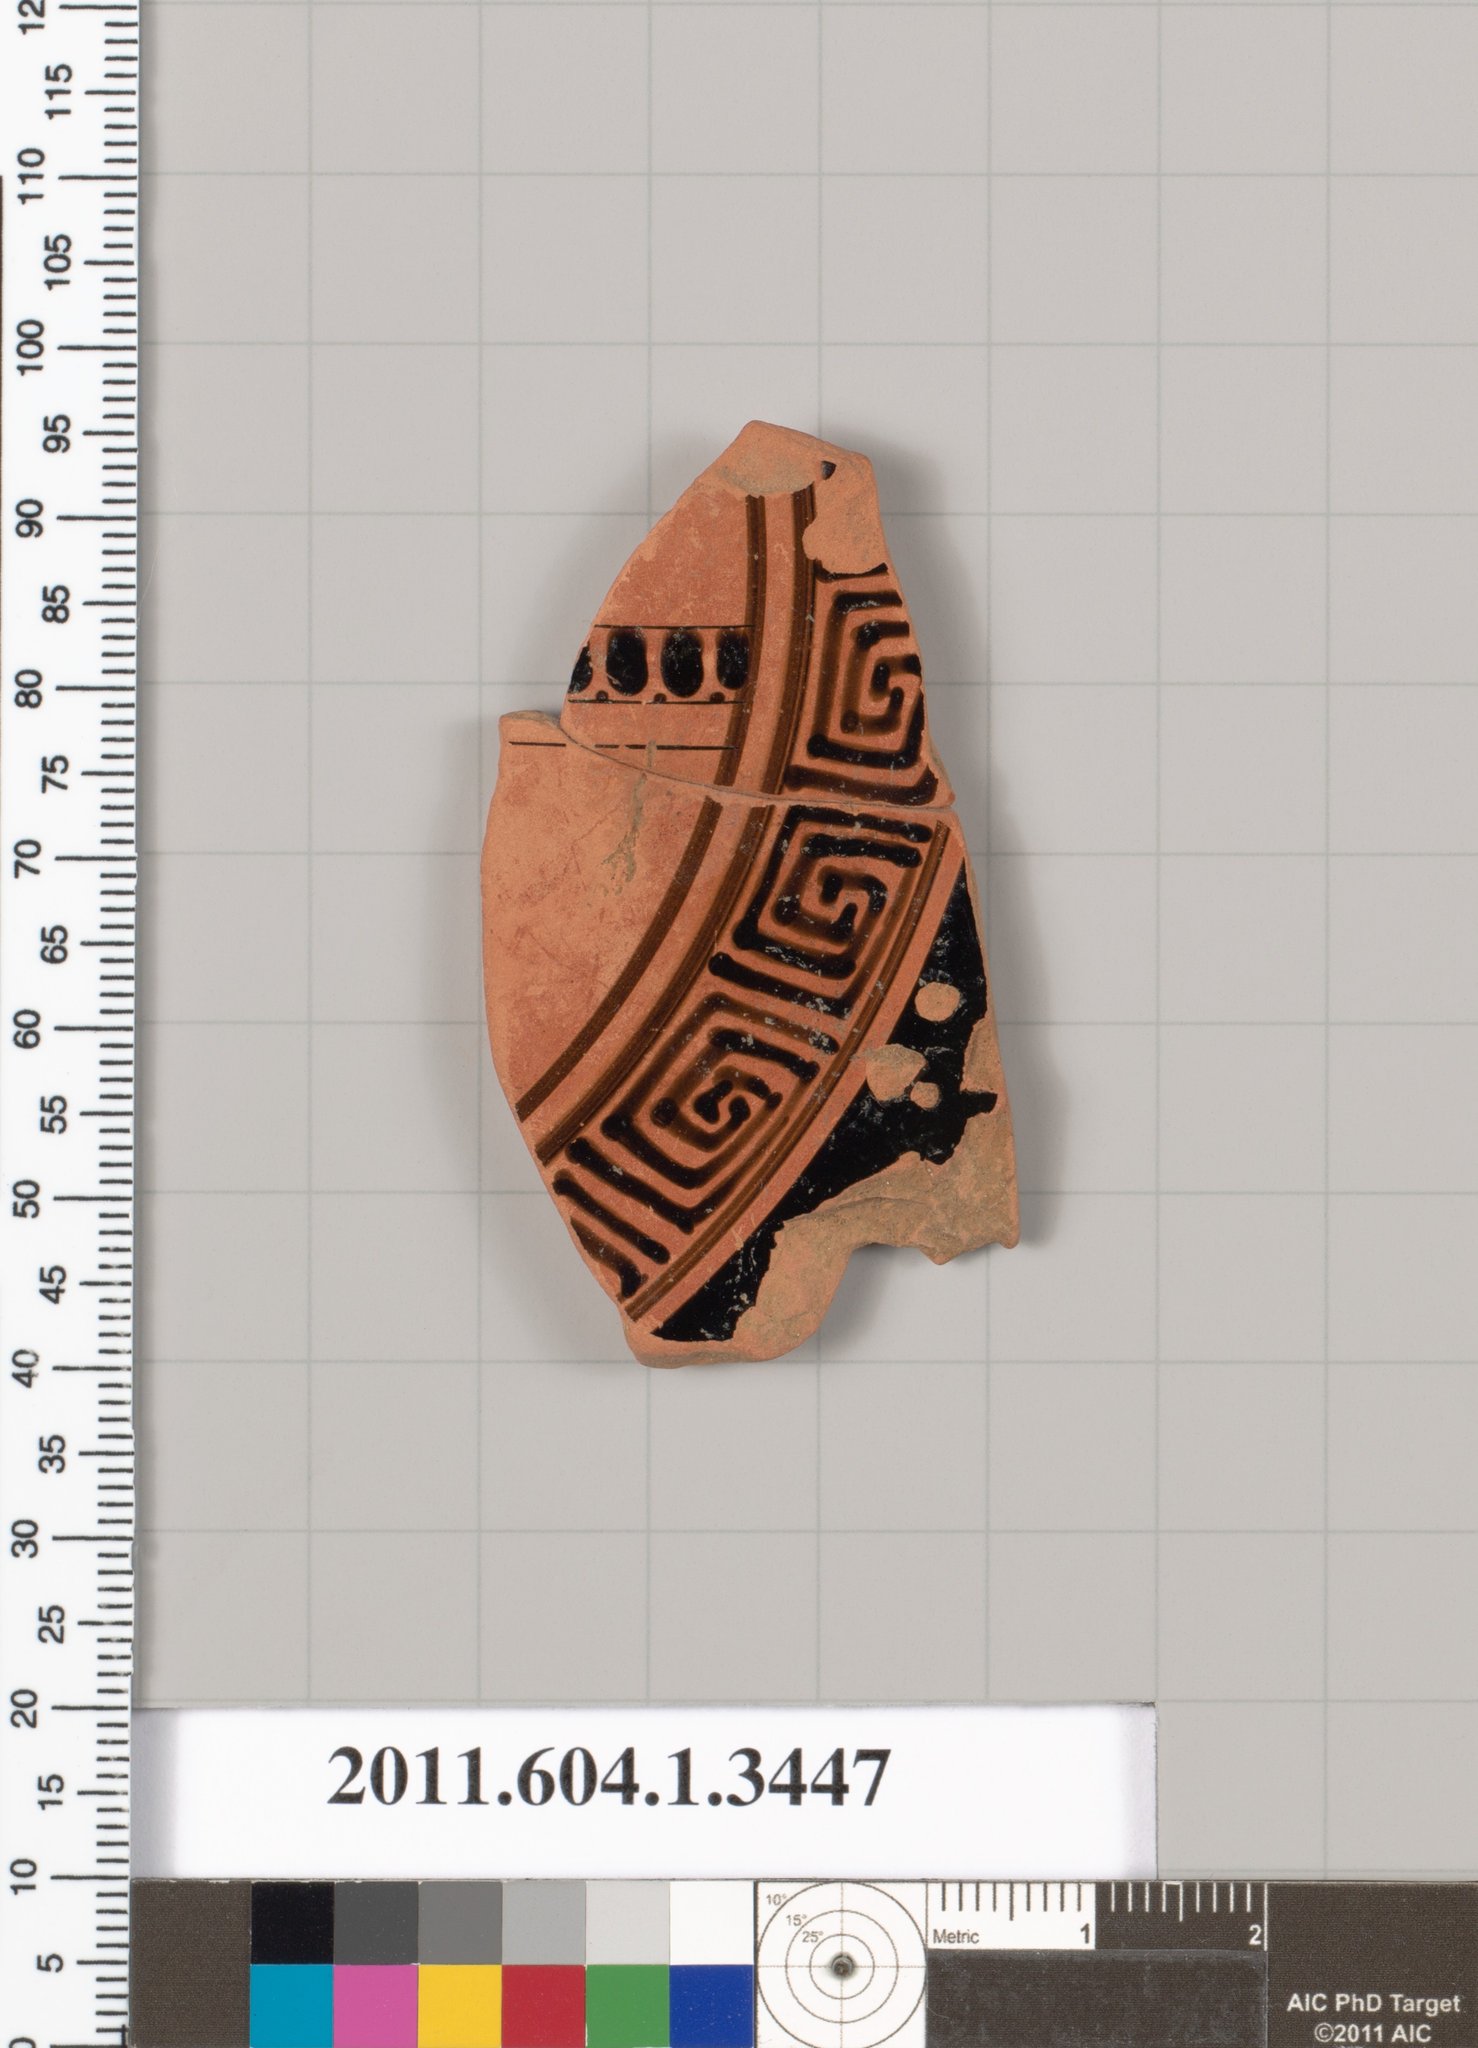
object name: kylix fragment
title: Terracotta fragment of a kylix (drinking cup)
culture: greek, attic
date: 500-476 BCE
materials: terracotta